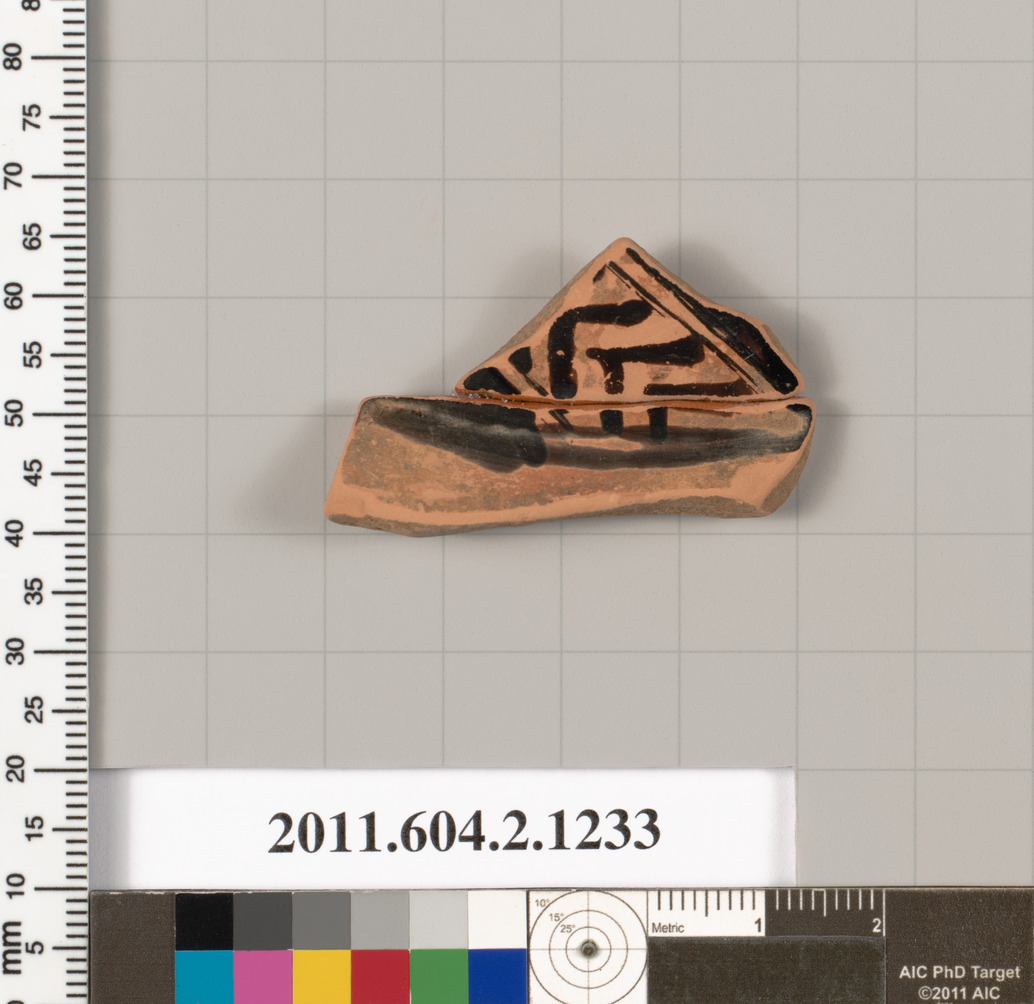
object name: head vase fragment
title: Terracotta fragment of a head vase?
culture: greek, attic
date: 475-451 BCE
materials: terracotta